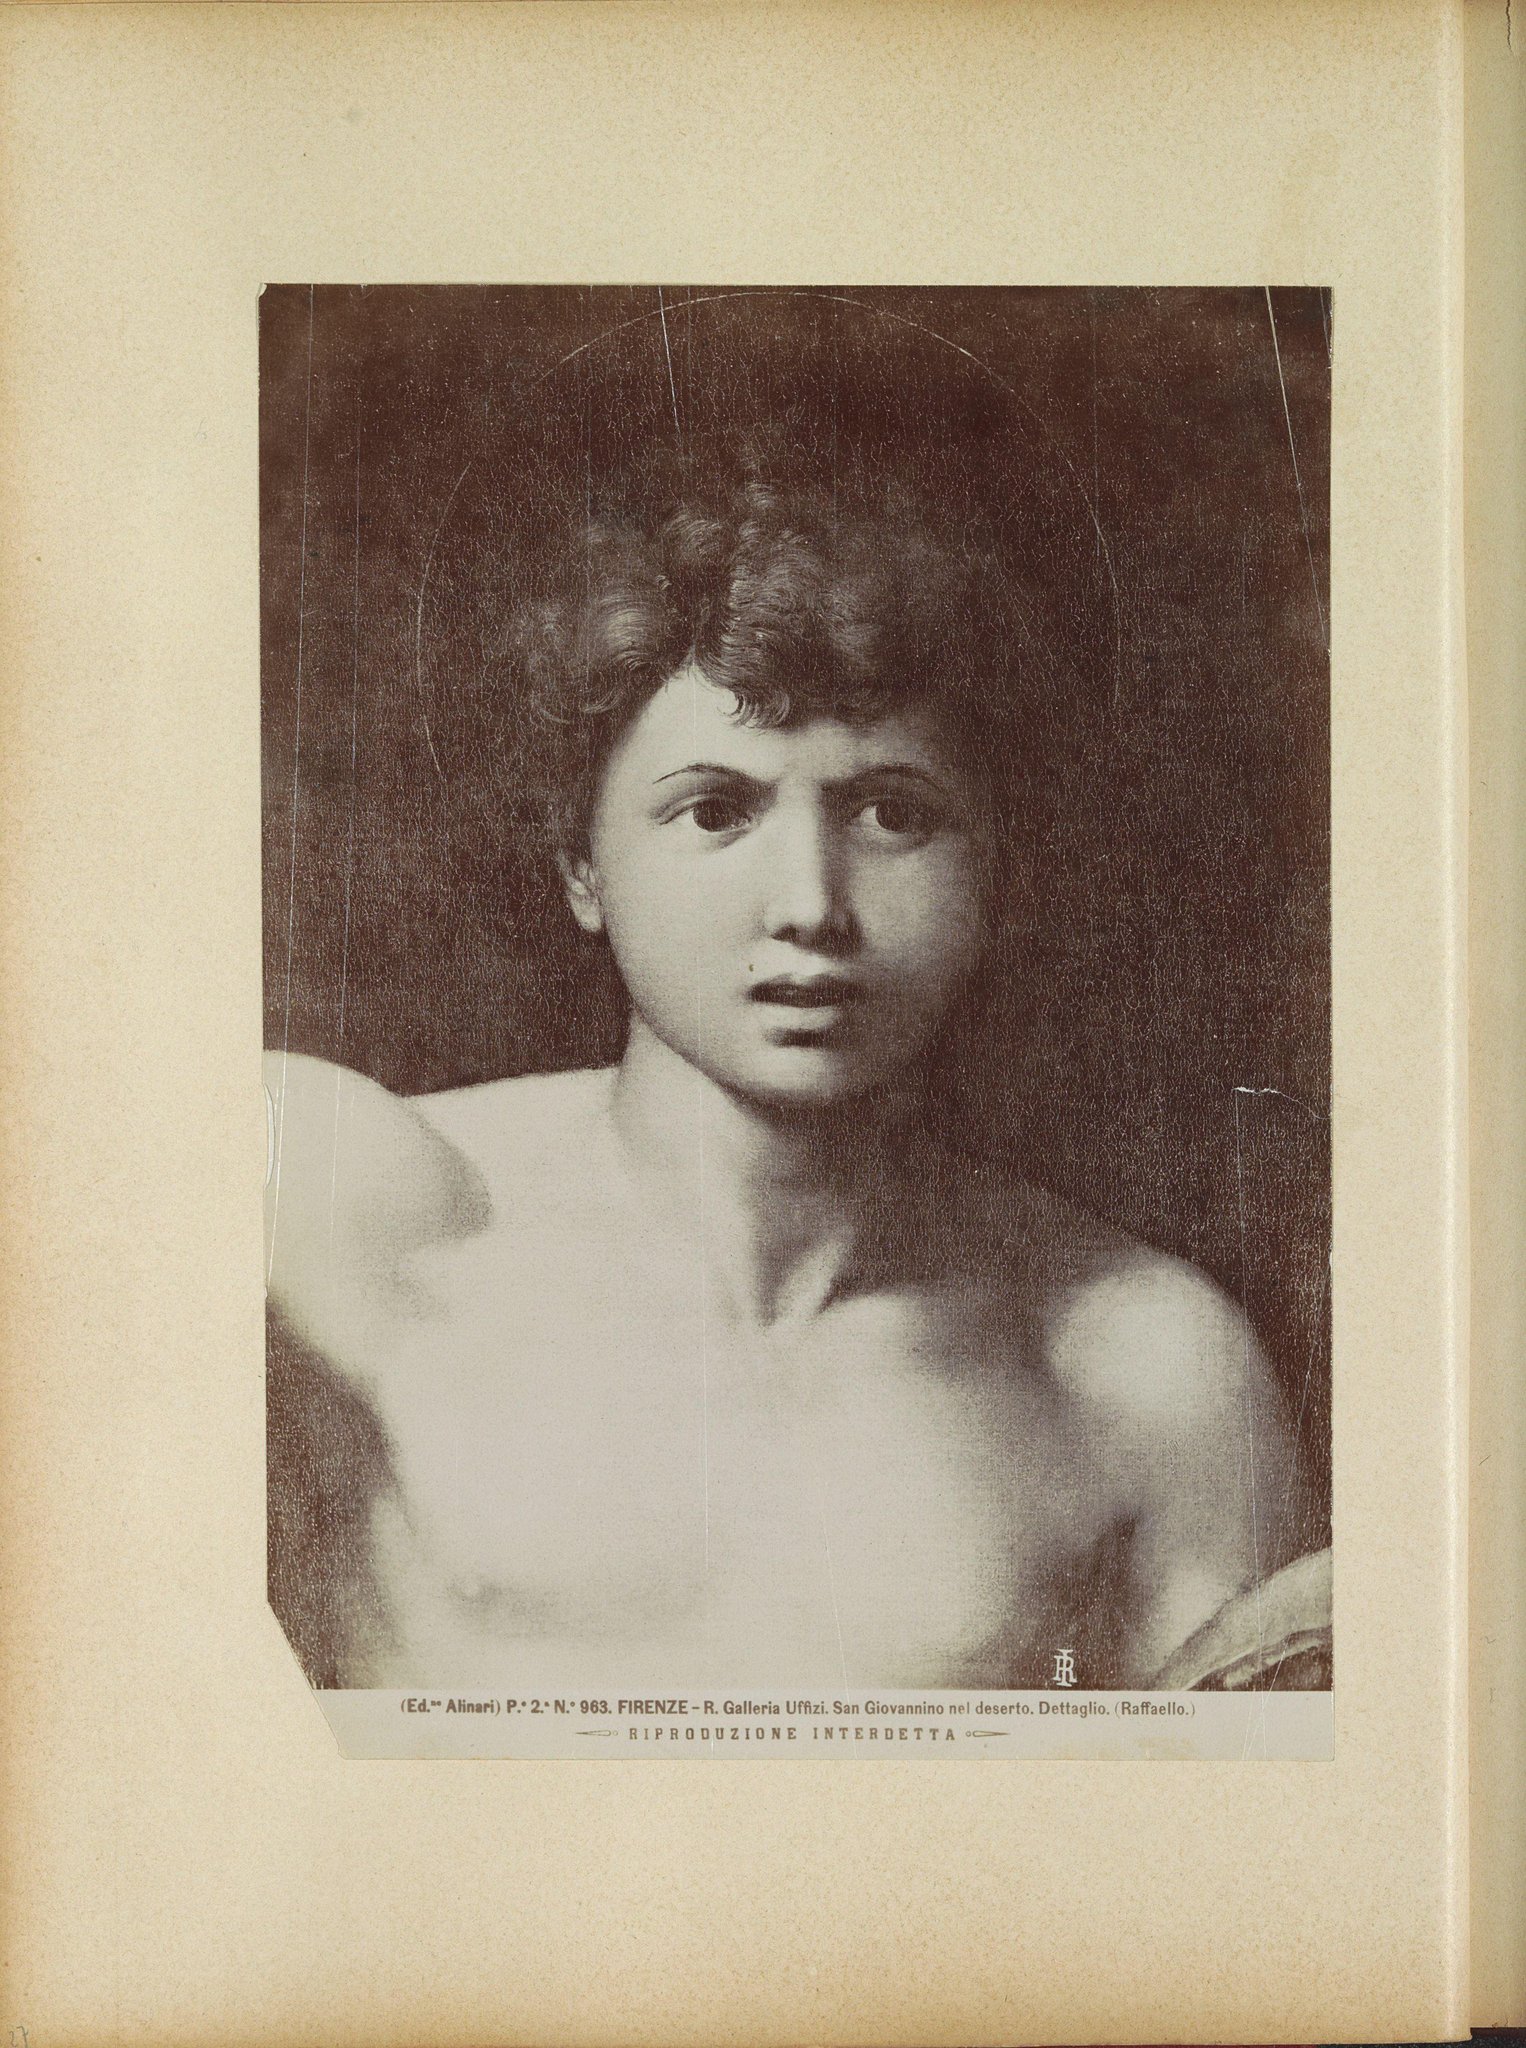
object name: photograph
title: Firenze - R. Galleria Uffizi. San Giovanni nel deserto. Dettaglio. (Raffaello)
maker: rafaël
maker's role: painter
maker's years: 1483-1520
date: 1860-1900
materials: photographic support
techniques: albumen print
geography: florence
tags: john the baptist; possible attributes: book, reed cross, baptismal cup, honeycomb, lamb, staff - early life of male saint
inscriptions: number: ‘P.e.2.a No. 963’, inscription: ‘IR’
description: Onderdeel van Fotoalbum met opnames van bezienswaardigheden in Italiaanse steden en van kunstwerken.